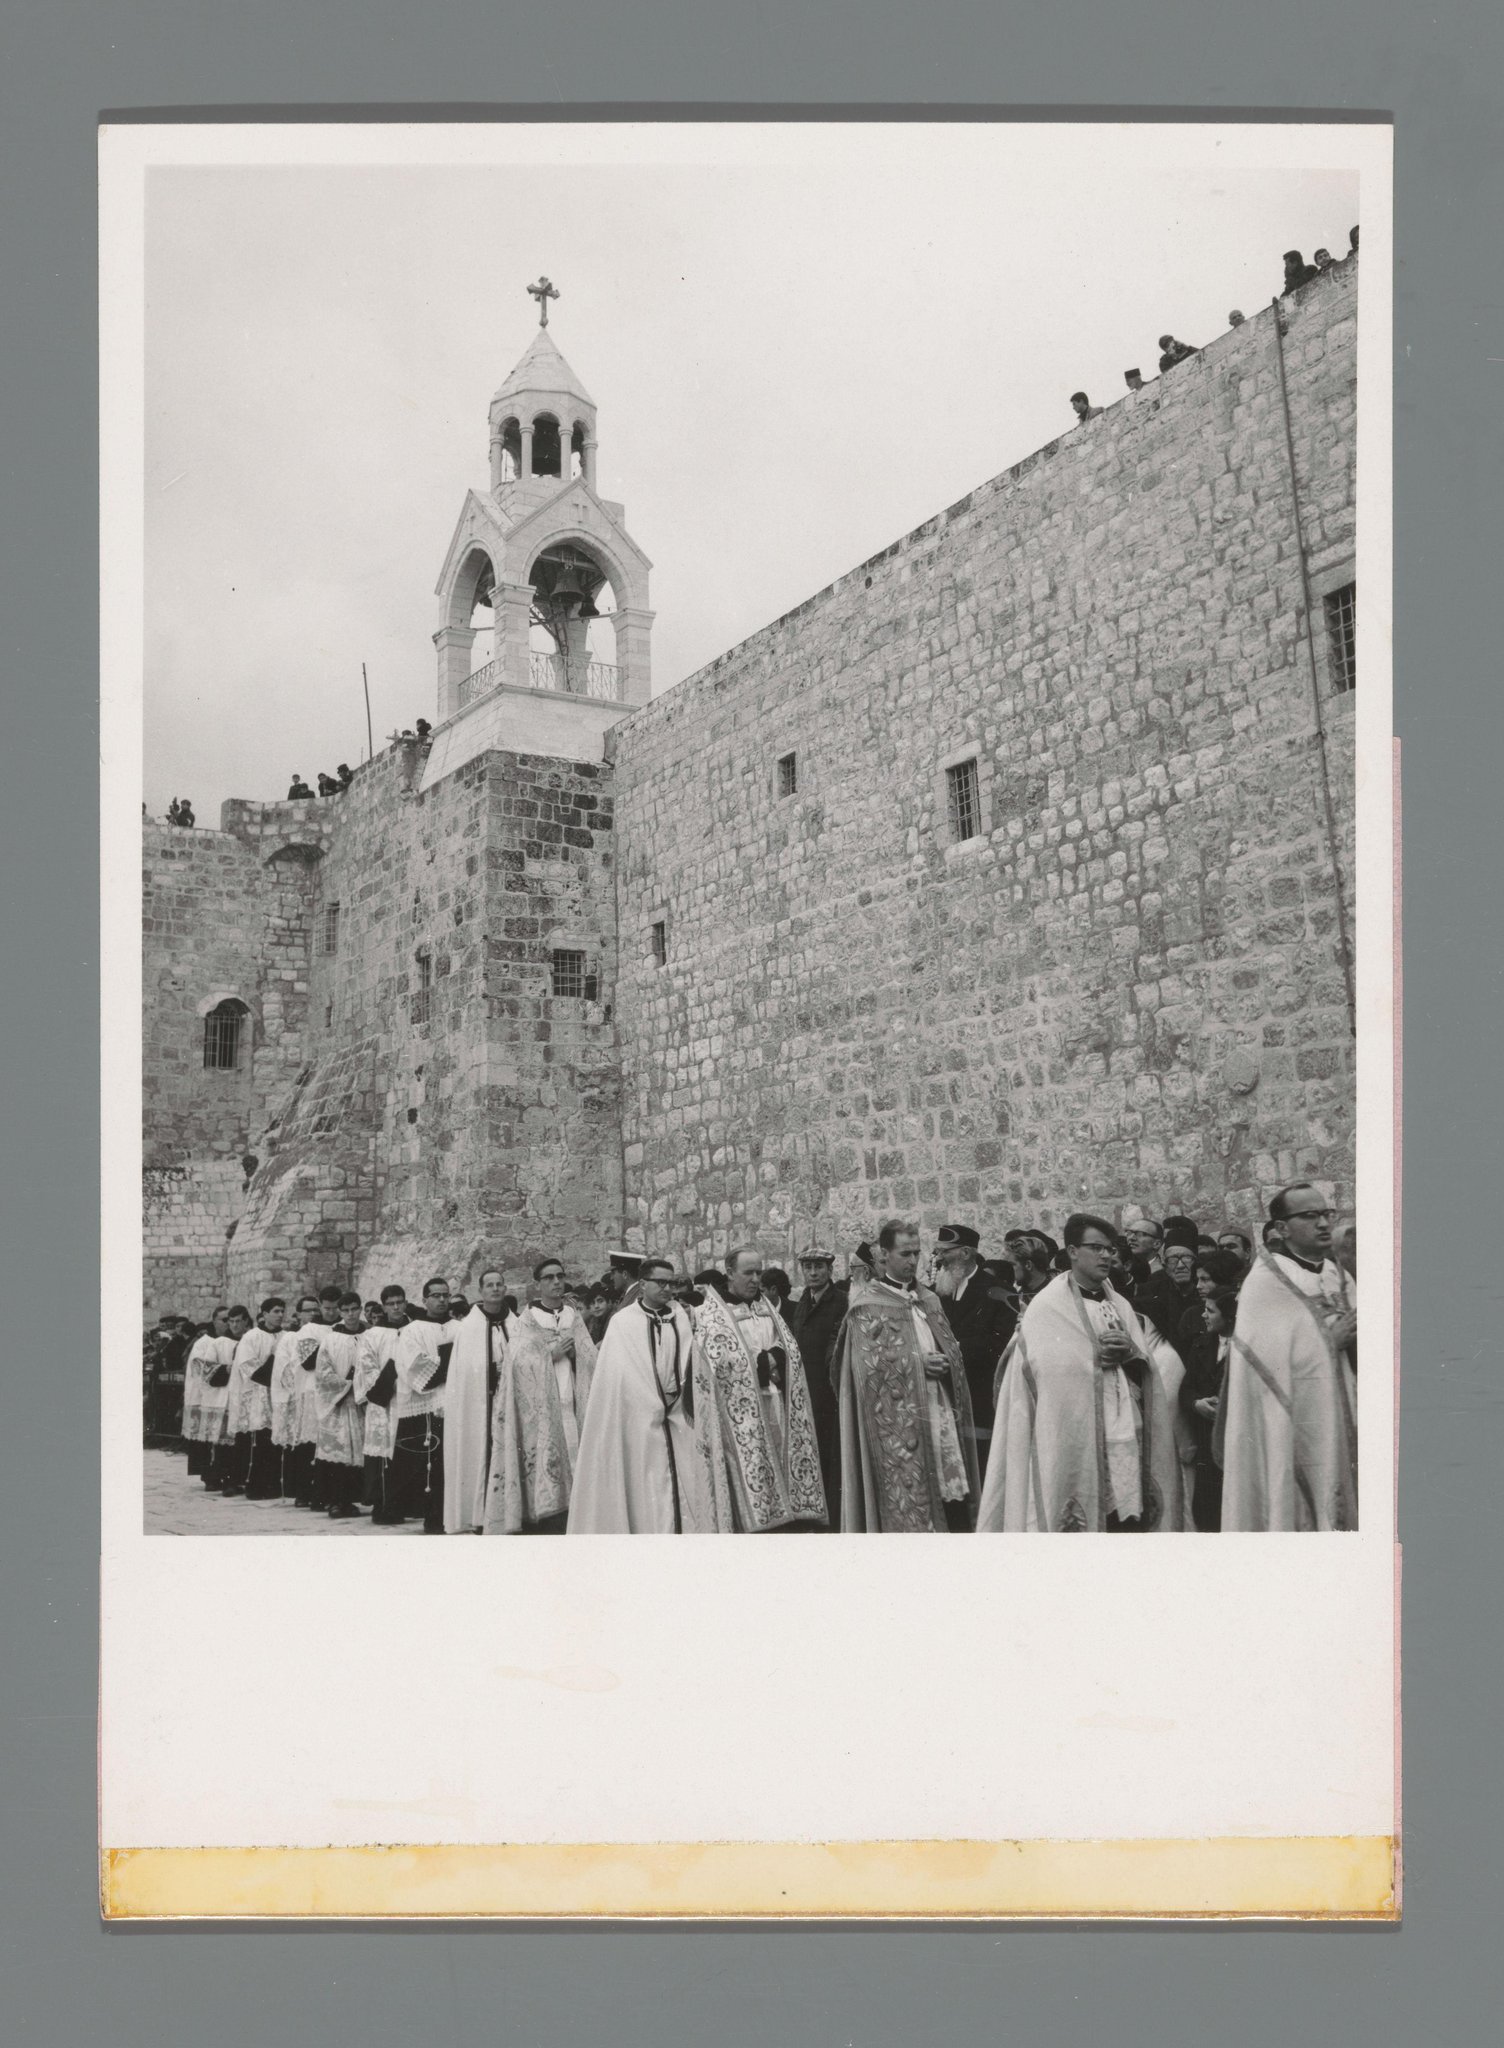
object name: news photograph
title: Kerstmisprocessie bij de Geboortekerk, Bethlehem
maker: Anonymous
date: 1960-1970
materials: paper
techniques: gelatin silver print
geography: bethlehem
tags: procession ~ christian religion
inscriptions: stamp: ‘Copyright/ ANEFO B.V./ Kerkstraat 310/ Amsterdam-C. (...)’, inscription: ‘De traditionele Kerstmis processie te Bethlehem (...) in deze periode volgeboekt.’